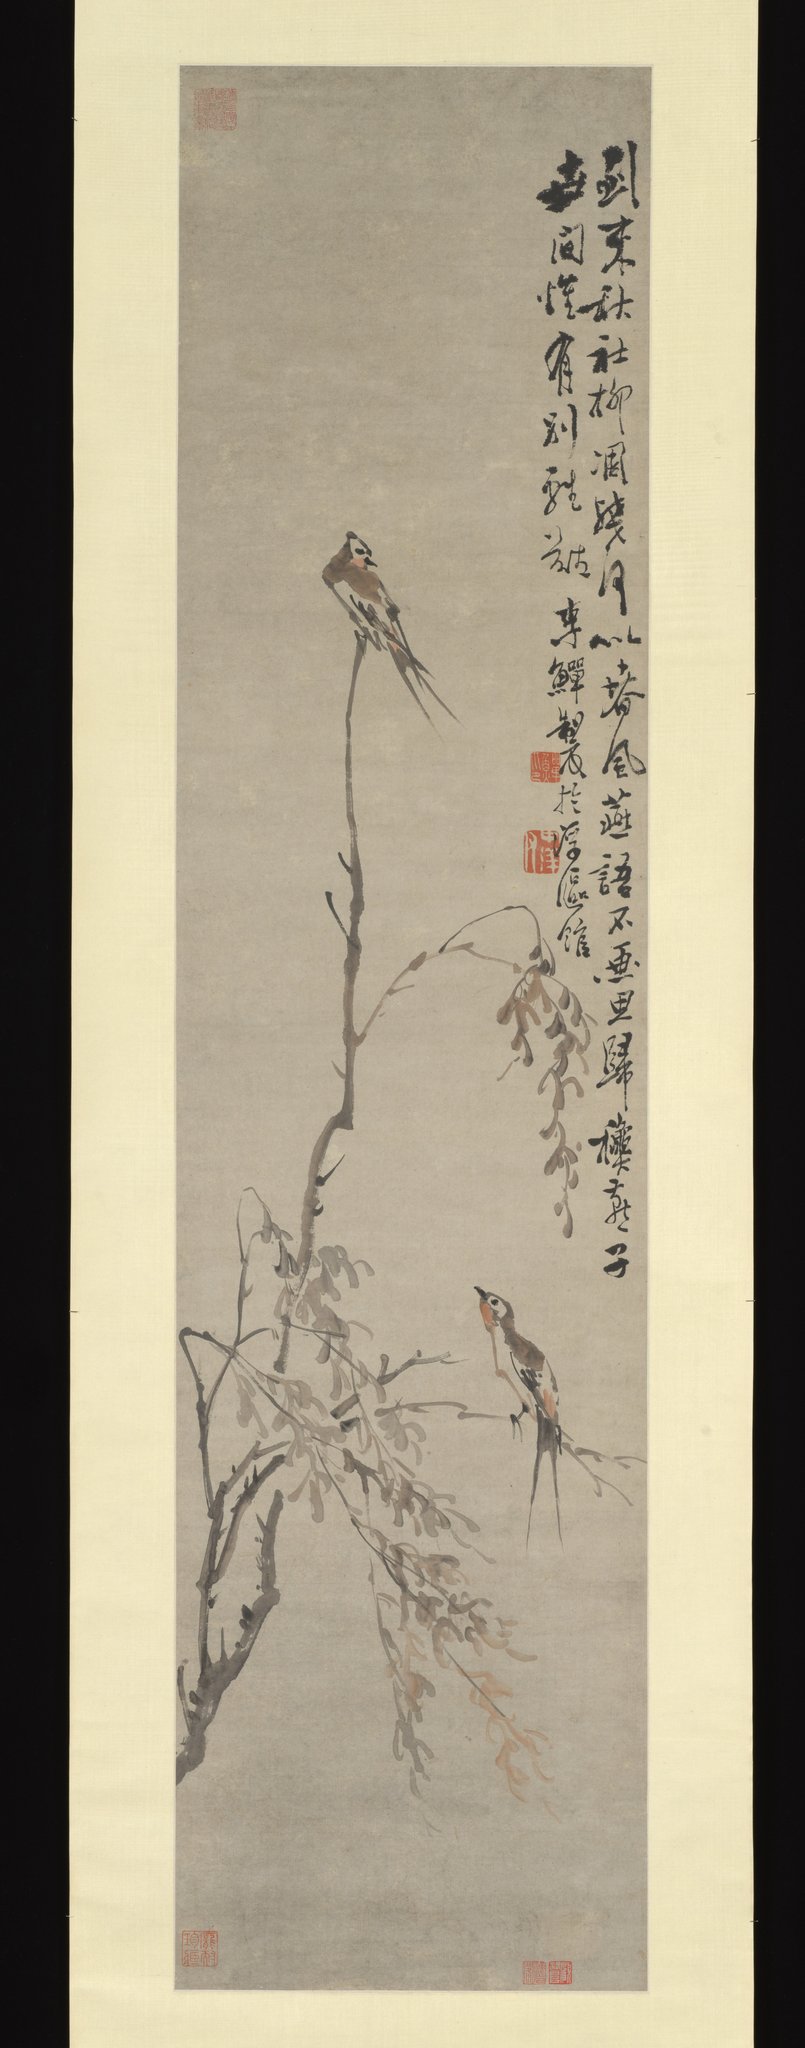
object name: hanging scroll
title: Swallows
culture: chinese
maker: li shan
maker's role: artist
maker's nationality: chinese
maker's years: 1686-1756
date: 1686-1756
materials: ink, paper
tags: birds